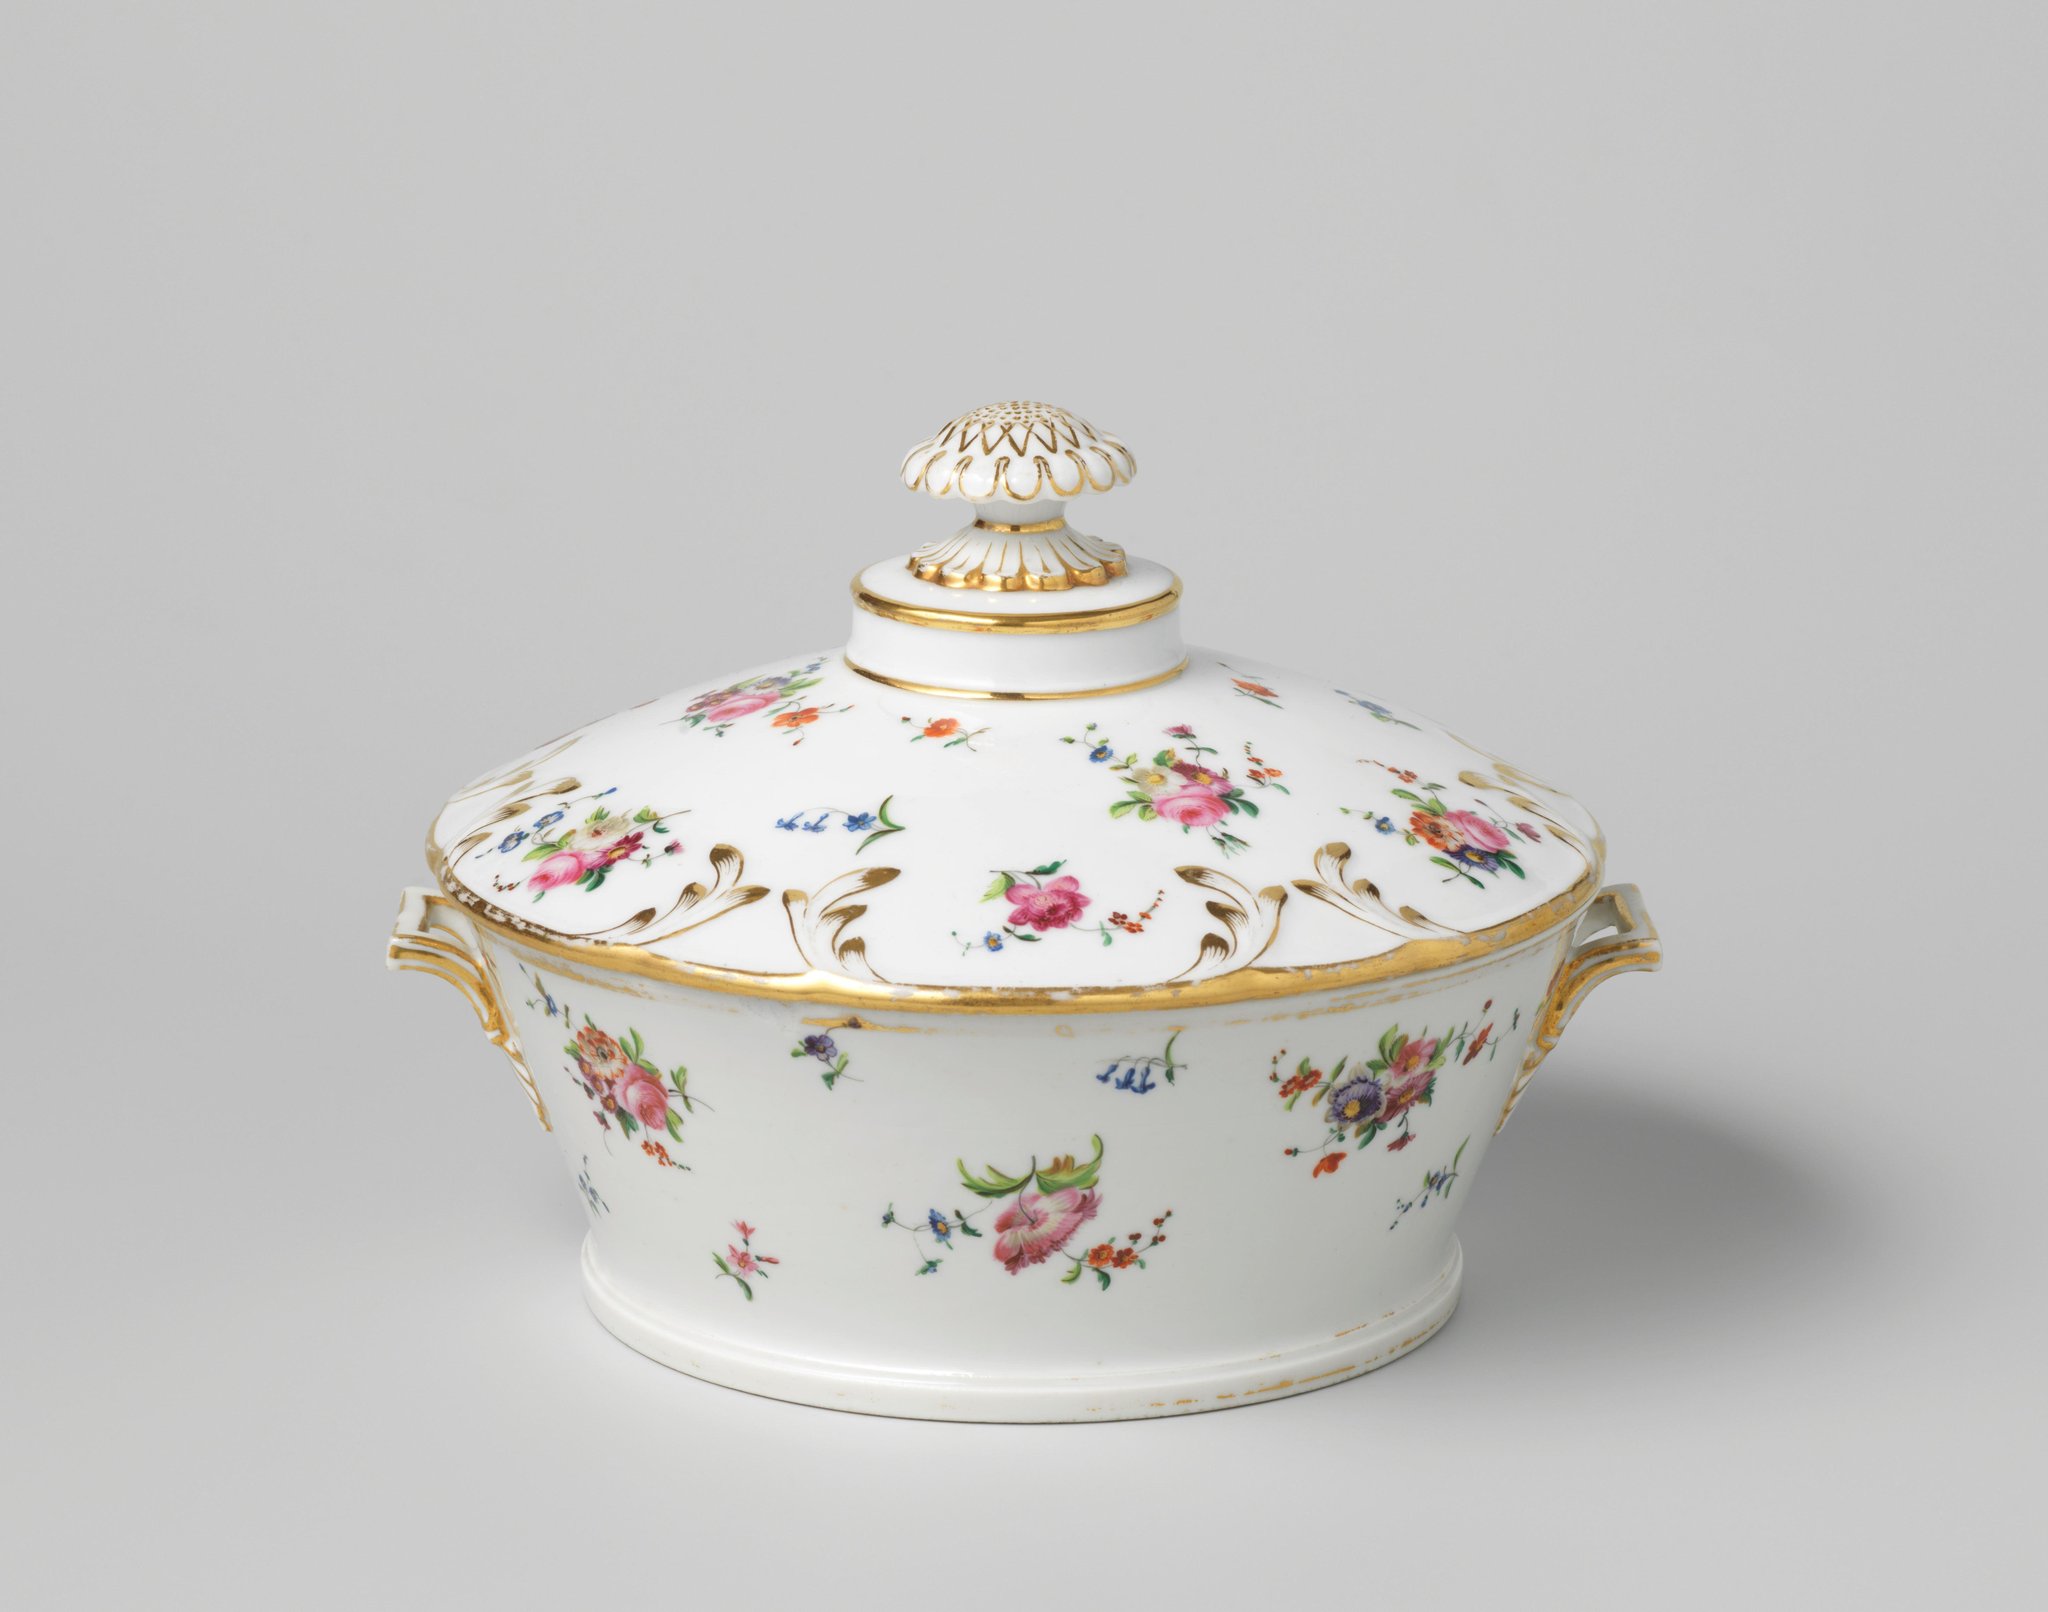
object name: lid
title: Cover of a dish with bouquets and flower sprays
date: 1839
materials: glaze, gold, paint, porcelain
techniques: firing, forming, gilding, turning, vitrification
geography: paris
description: Deksel van een schaal van porselein, beschilderd op het glazuur in blauw, rood, roze, groen, geel, paars, zwart en goud. Versierd met boeketten van verschillende bloemen en strooibloemen. Vanuit de gelobde, gouden rand, gemodelleerde bladranken, aangezet met goud. Dekselknop in de vorm van een bloem.